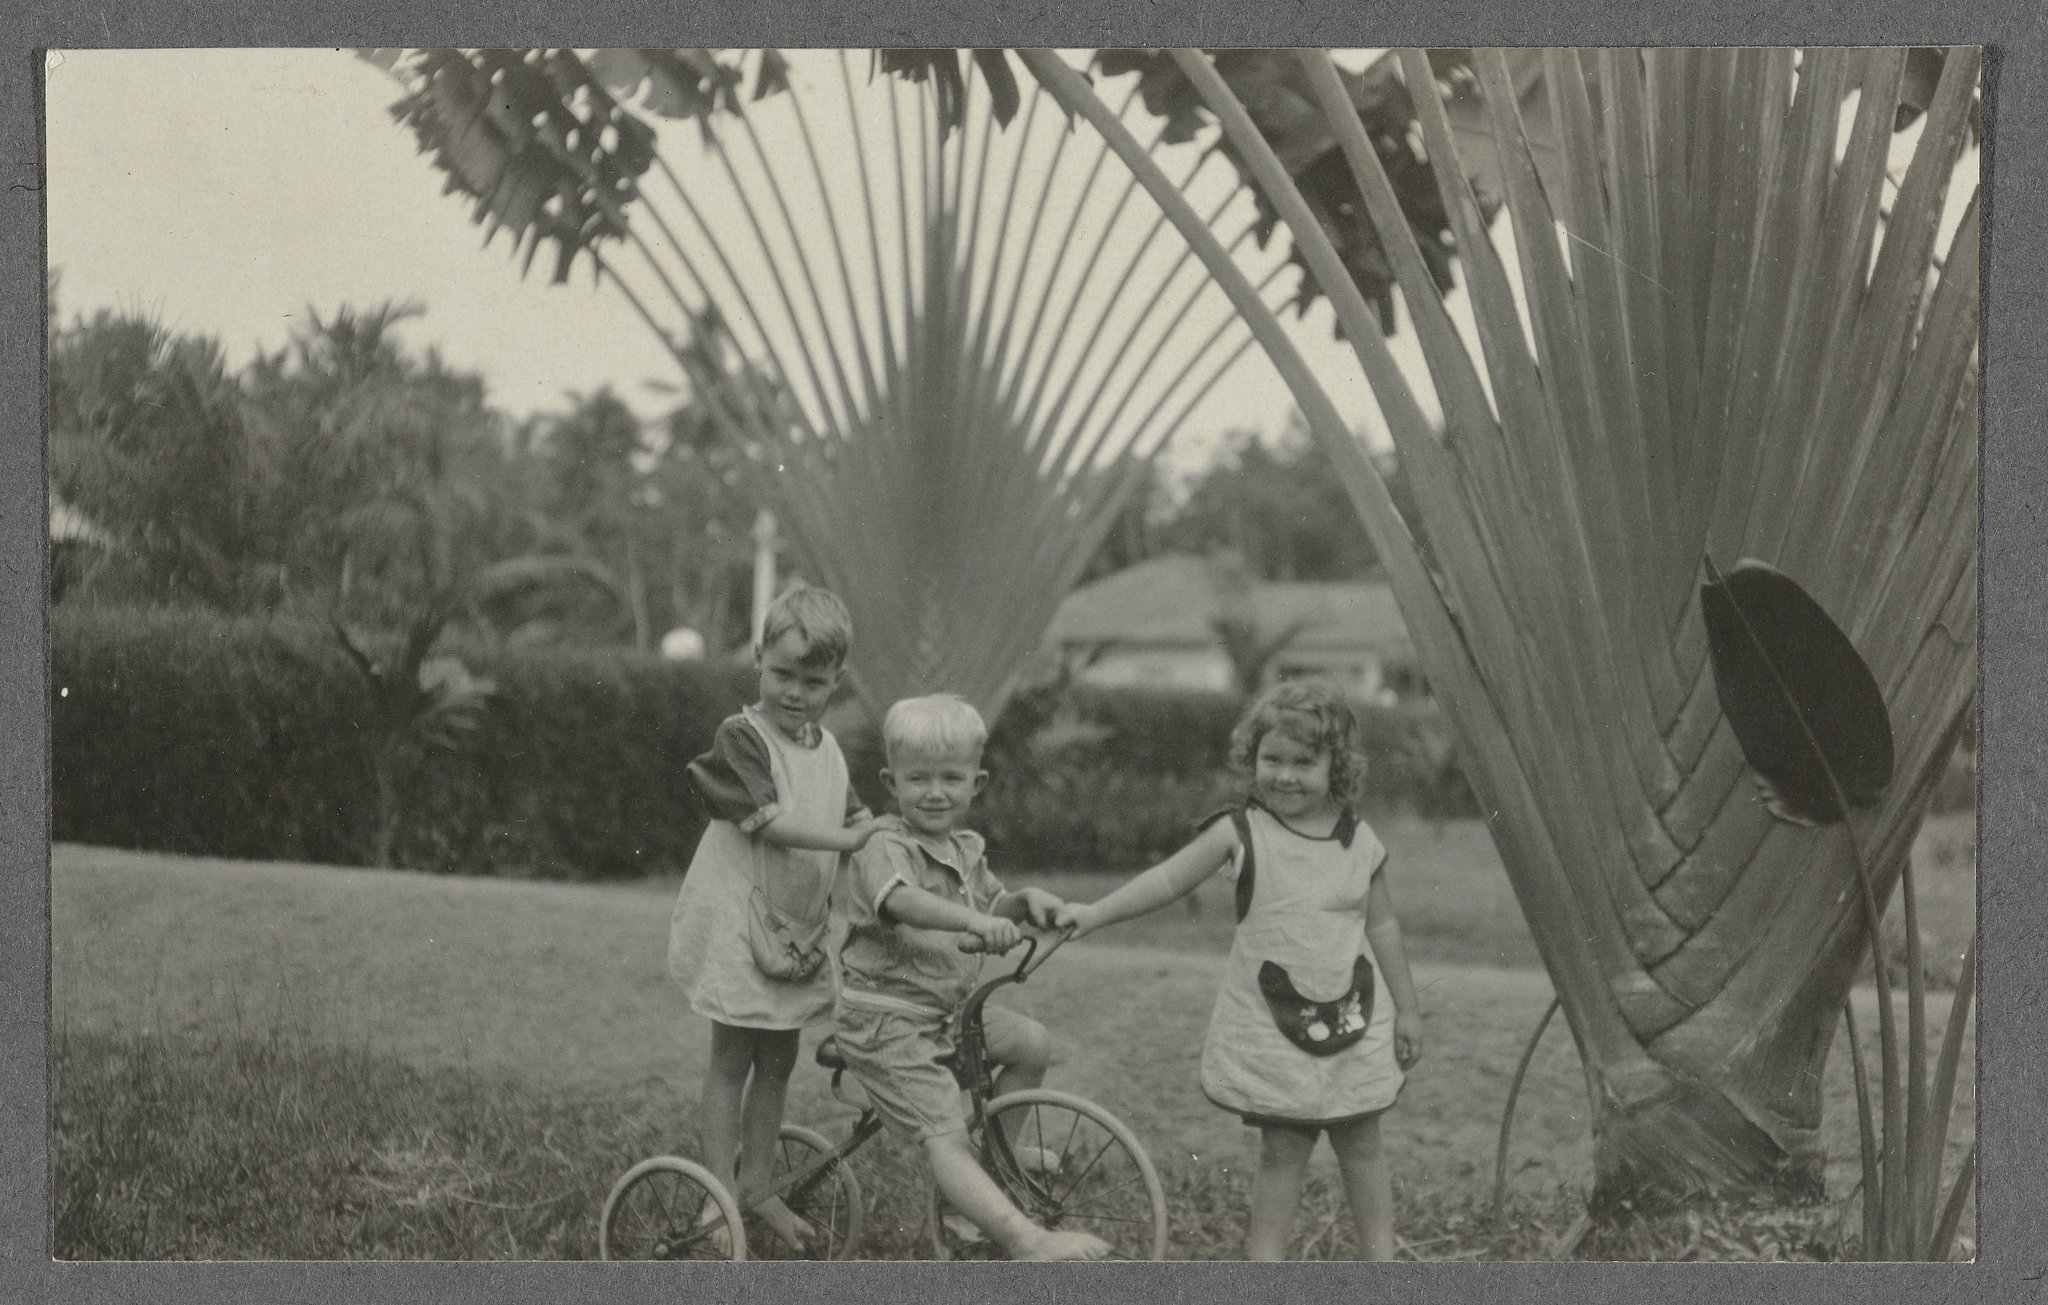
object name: photograph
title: Klaas en Tiny Kleiterp en een onbekende kleuter (midden) spelend met een driewieler in een tuin in Singkawang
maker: klaas kleiterp (i)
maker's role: arts, officier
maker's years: 1892-1943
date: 1910-1924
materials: paper, photographic support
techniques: gelatin silver print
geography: singkawang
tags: tricycle, garden, child, (playing with) toys, dutch east indies, the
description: Onderdeel van Fotoalbum van de familie Kleiterp-Vermeulen met opnames van de kinderen Klaas en Tiny in Nederlands-Indië.